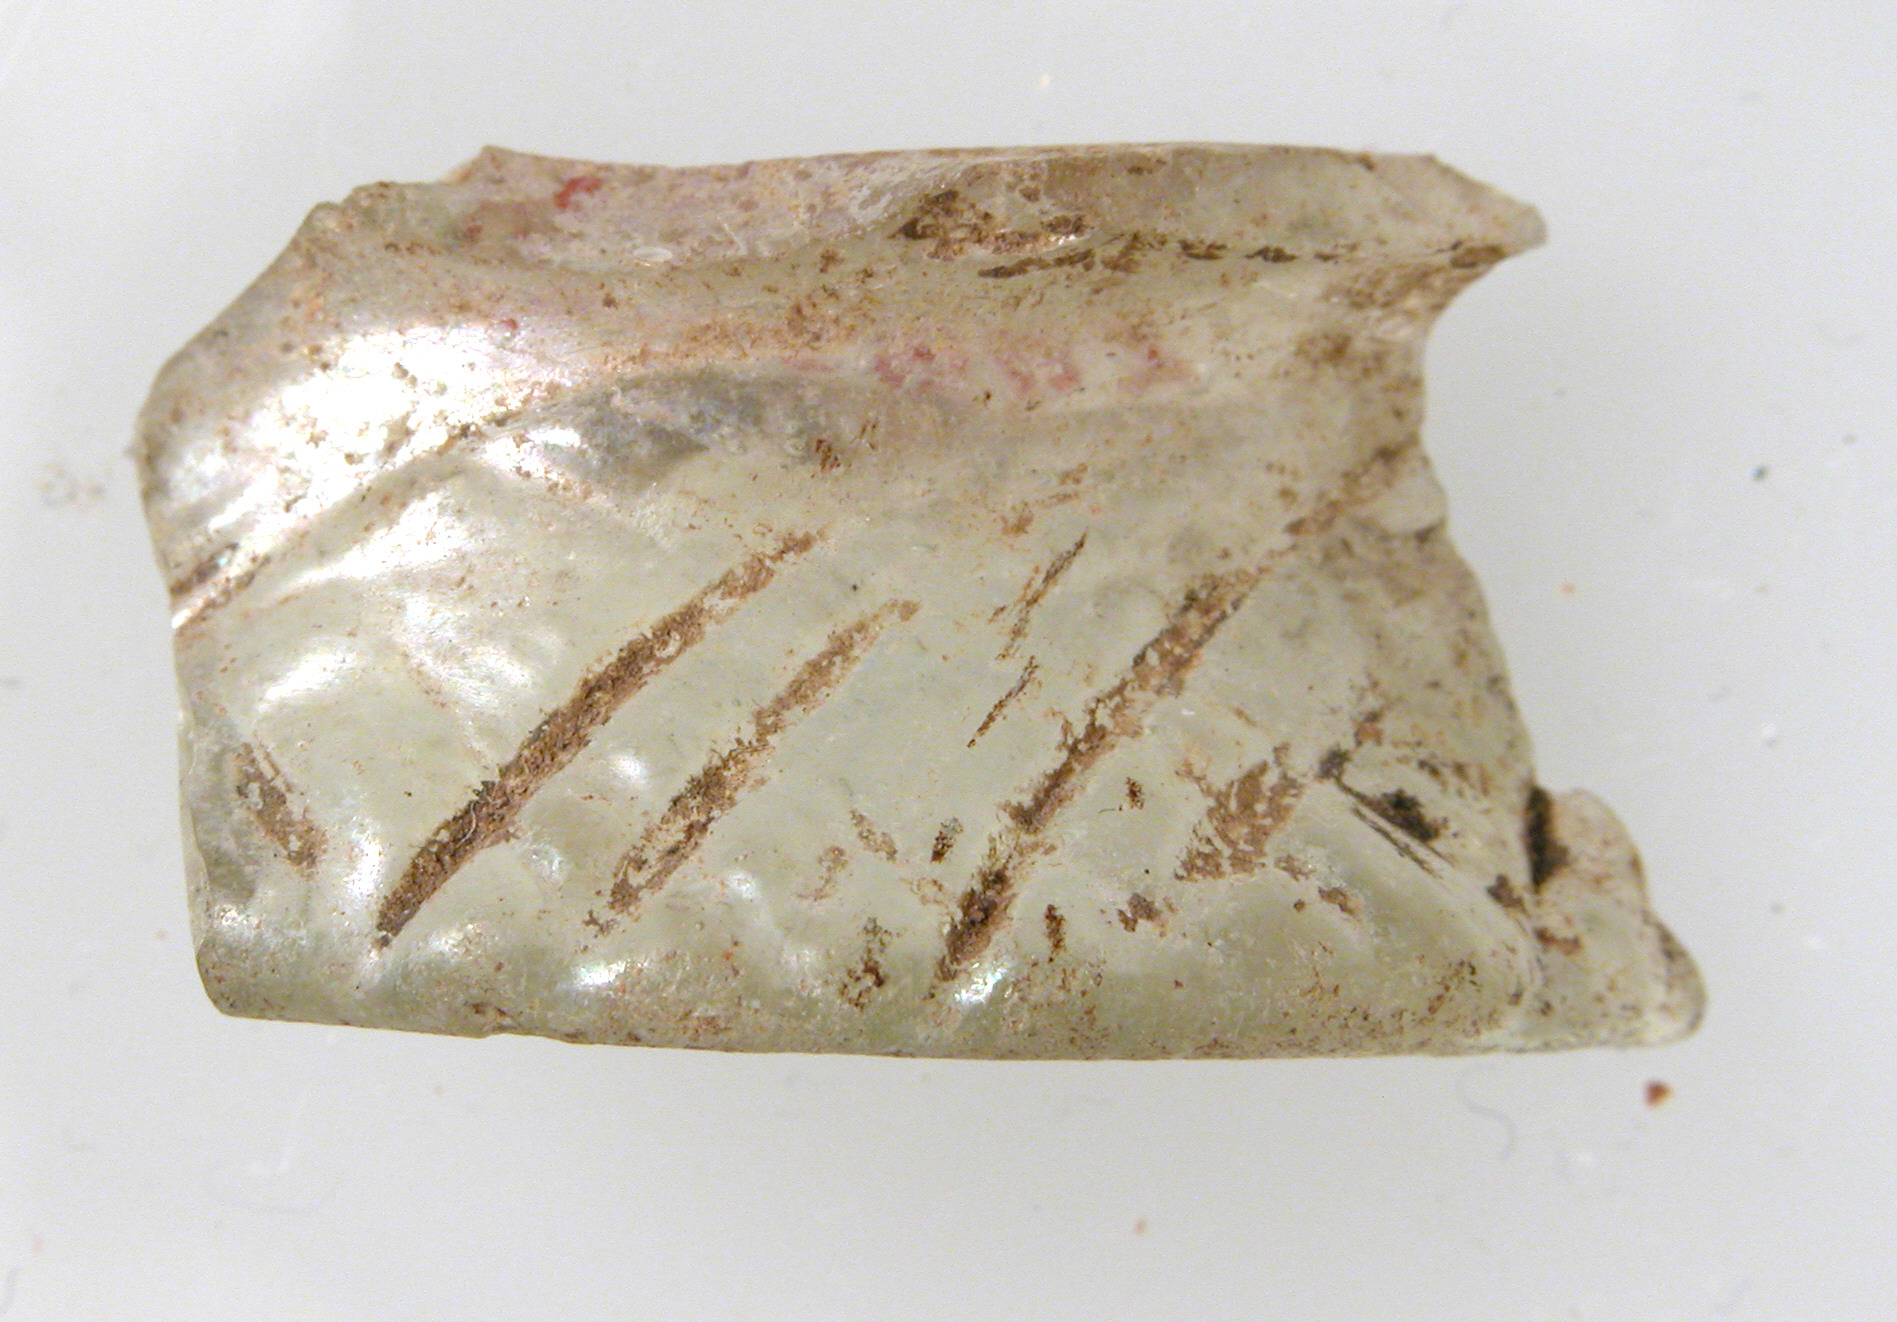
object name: fragment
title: Glass Fragment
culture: coptic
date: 301-433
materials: glass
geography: egypt